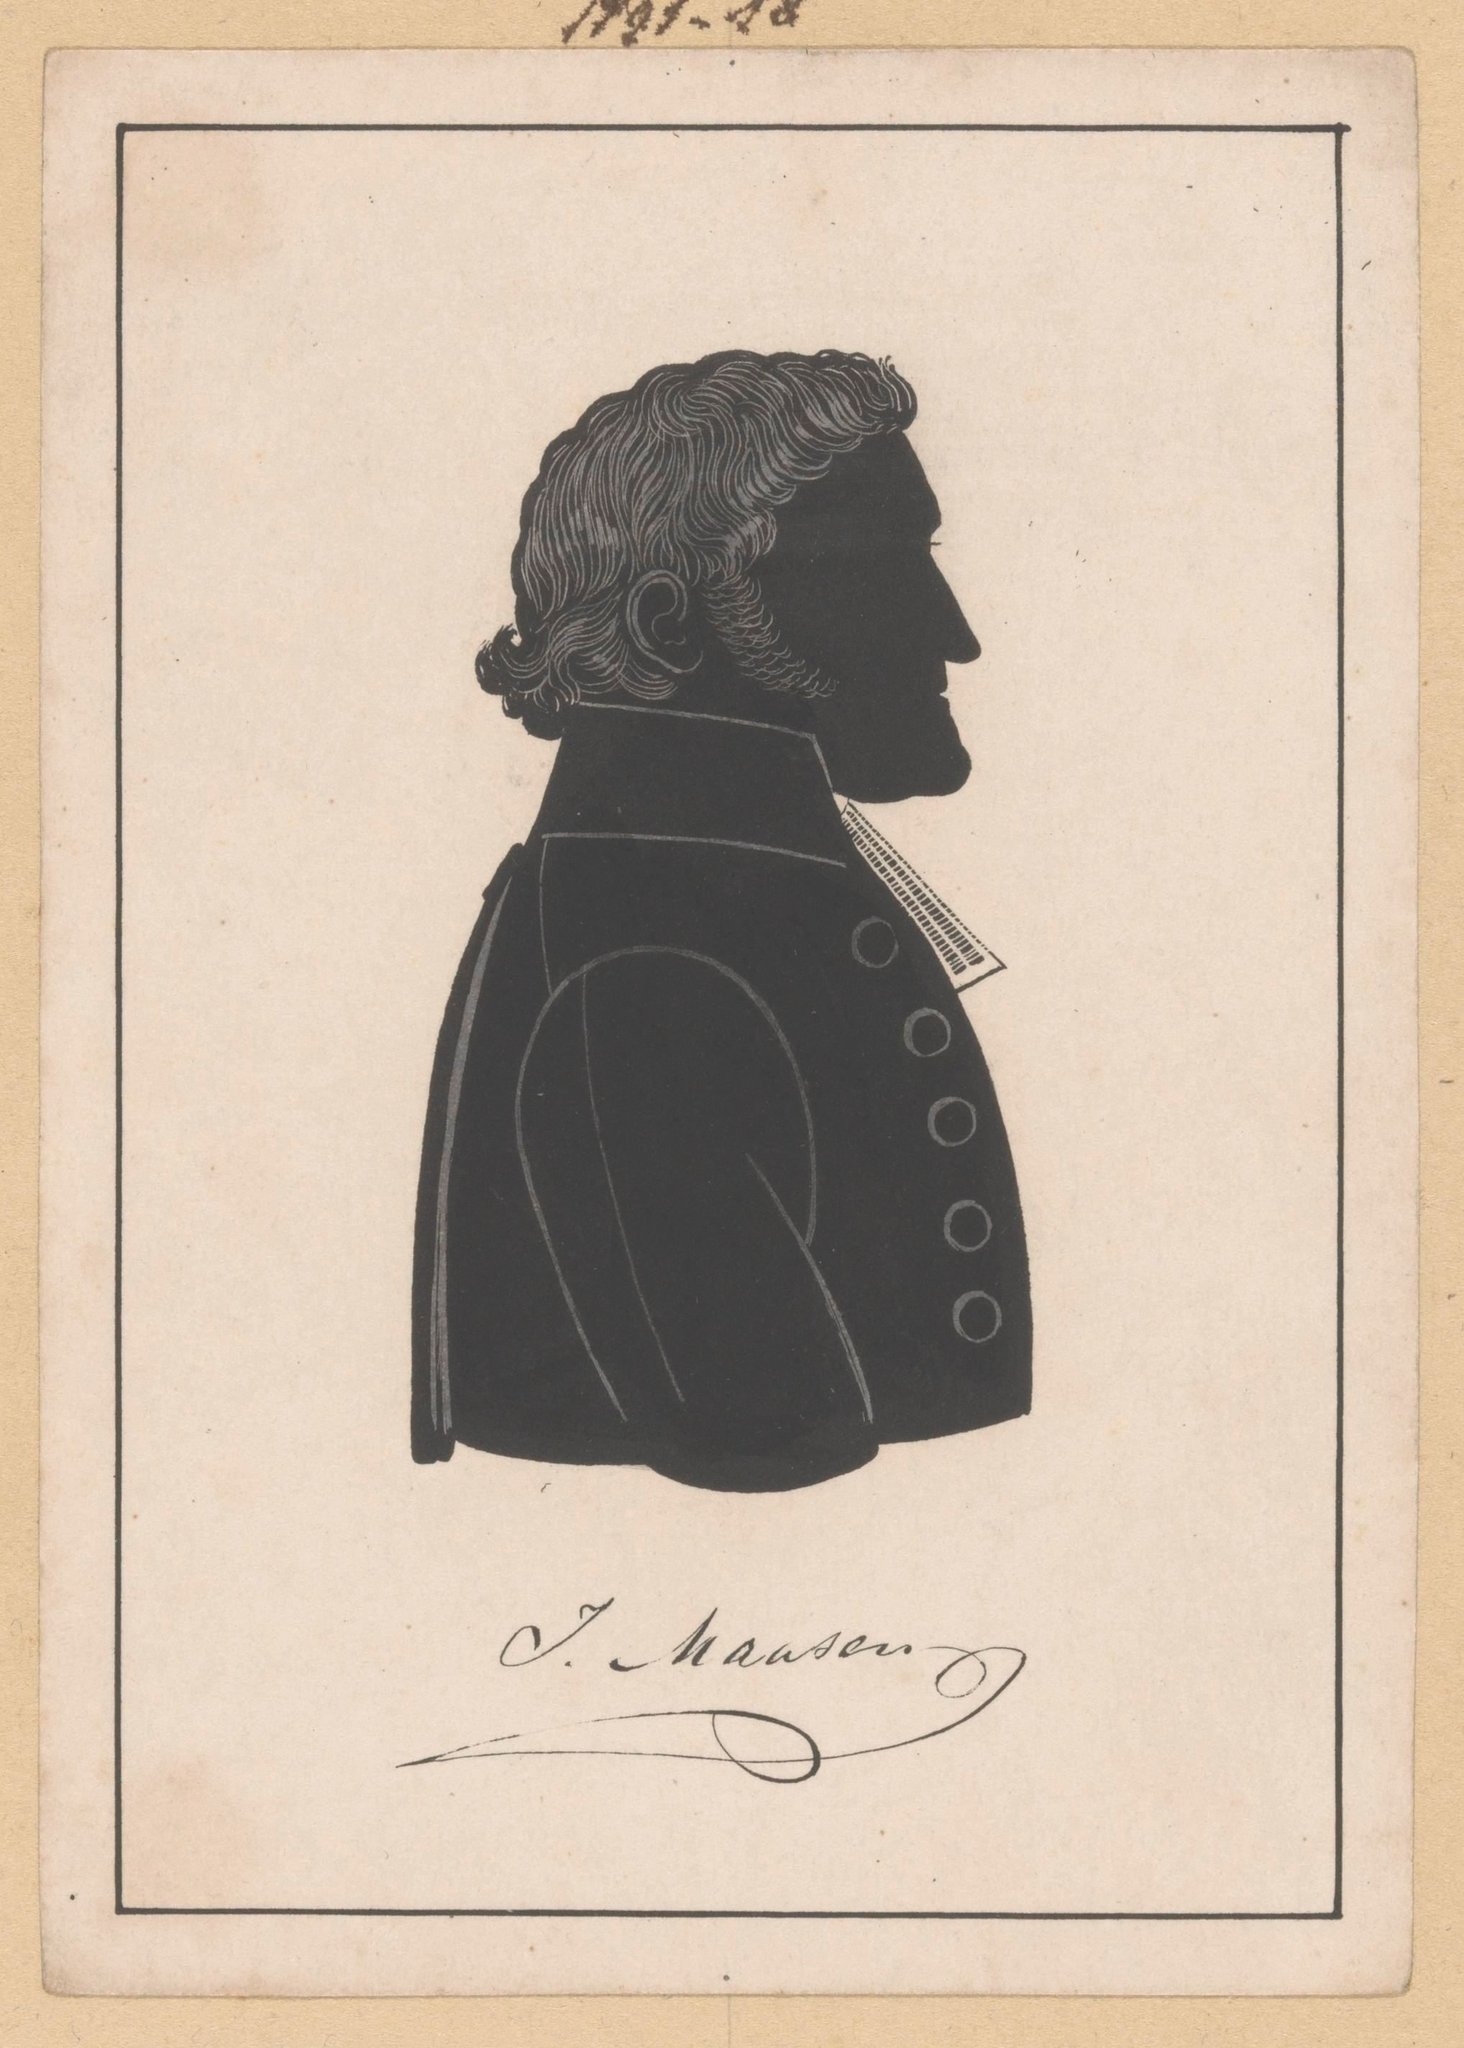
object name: print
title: Silhouetportret van J. Mansen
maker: pieter barbiers (iv)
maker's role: painter, print maker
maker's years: 1798-1848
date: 1809-1848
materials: paper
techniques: hand coloring, lithograph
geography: netherlands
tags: historical persons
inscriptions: collector's mark: Lugt 2228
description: Onder het portret de signatuur van de geportretteerde.